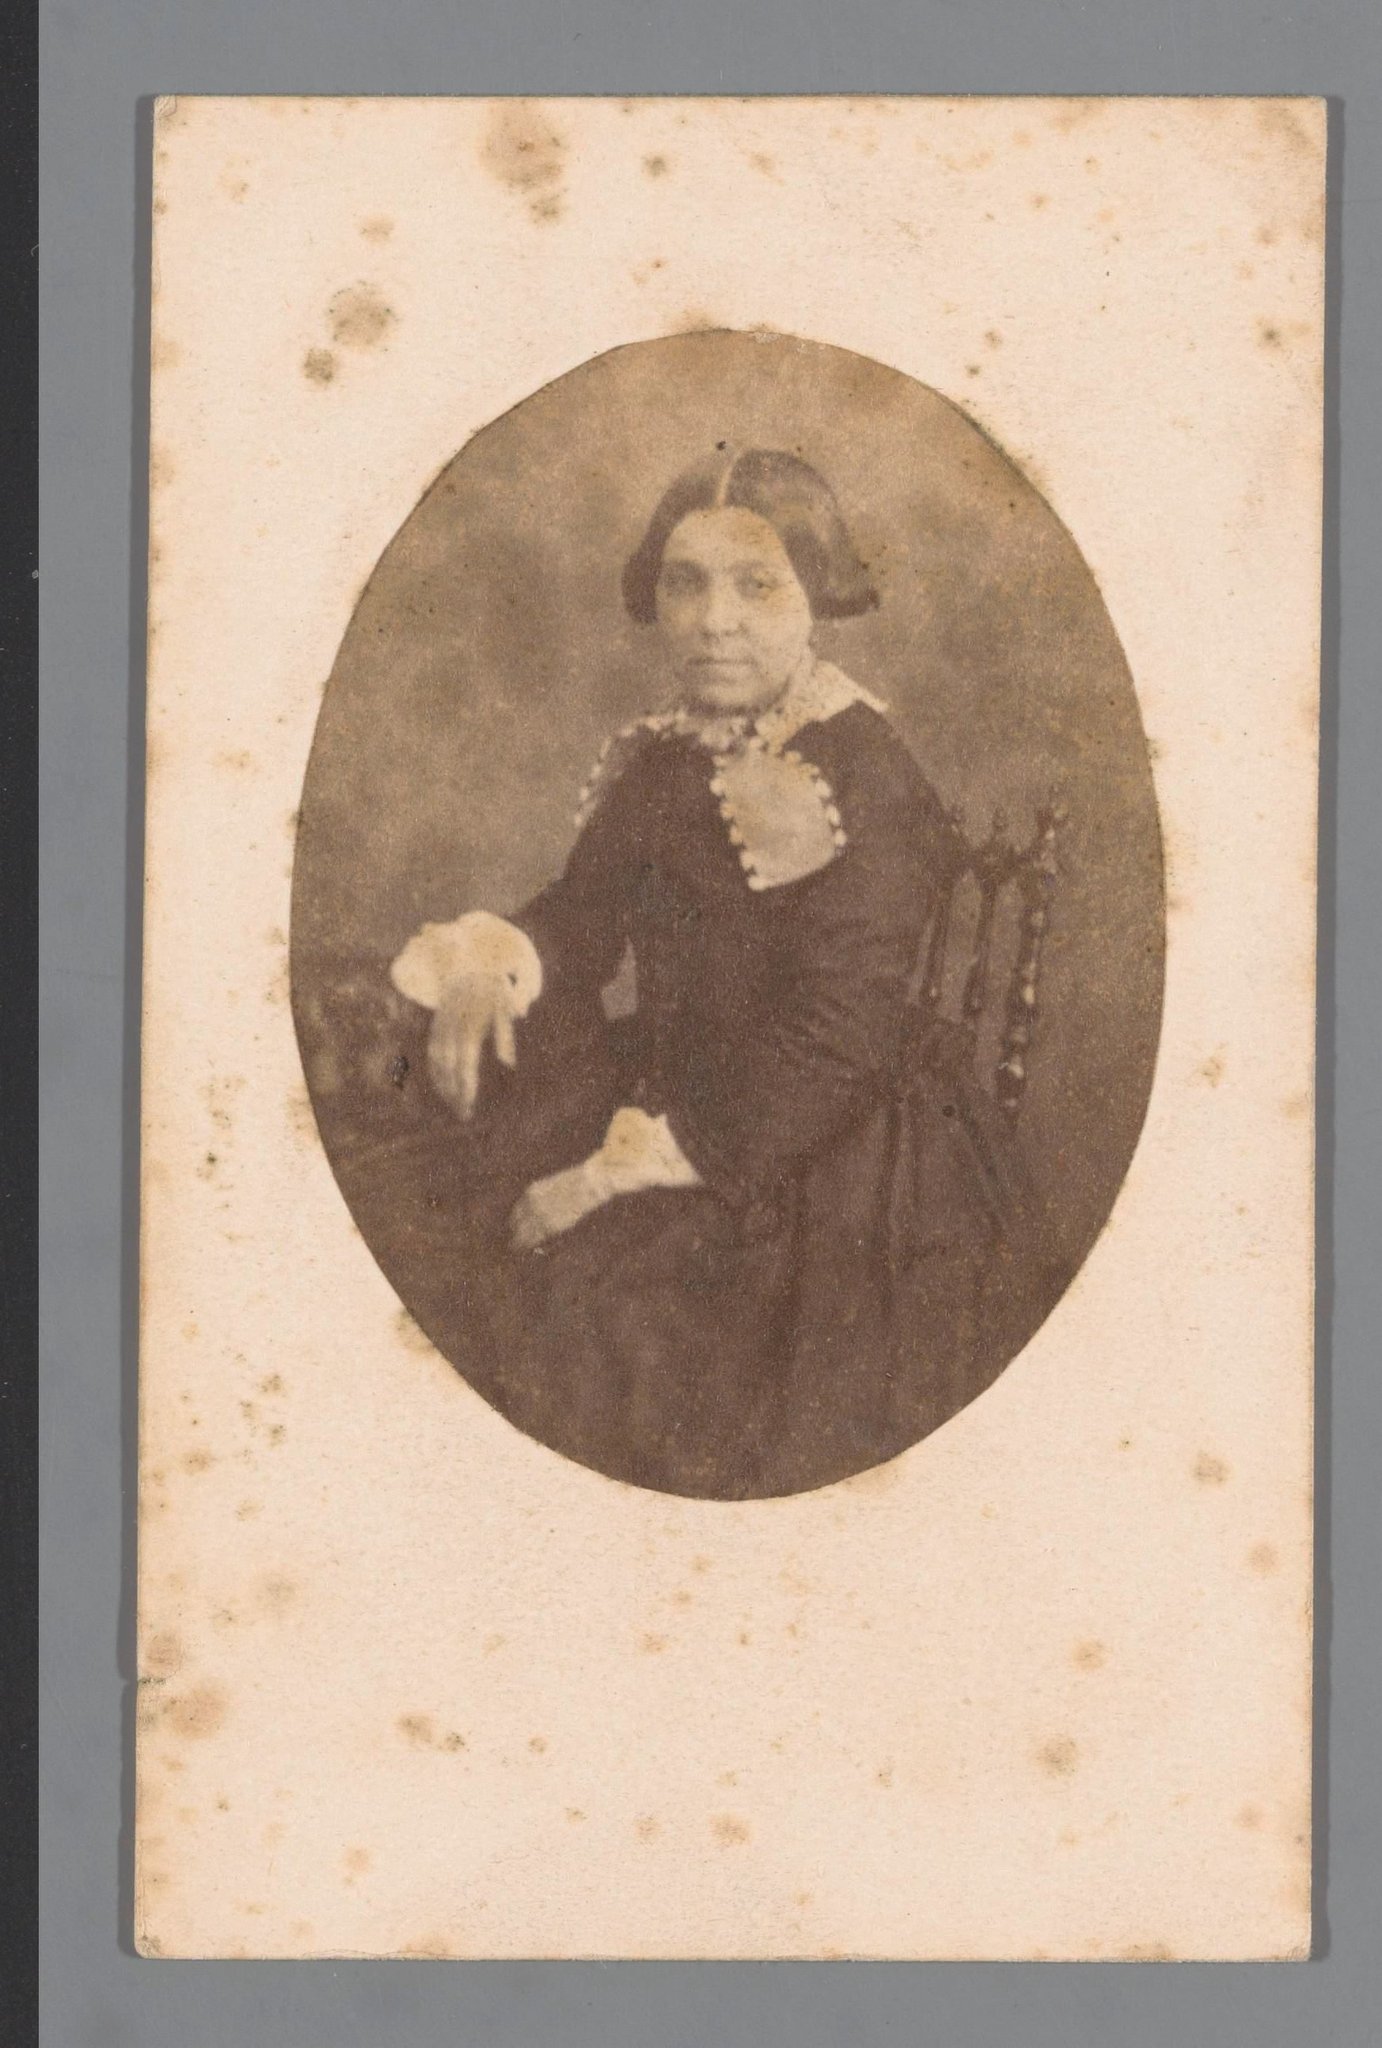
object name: photograph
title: Portret van een onbekende vrouw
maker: Anonymous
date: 1850-1900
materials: cardboard, photographic support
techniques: albumen print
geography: france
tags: historical persons not known by name - bb - woman